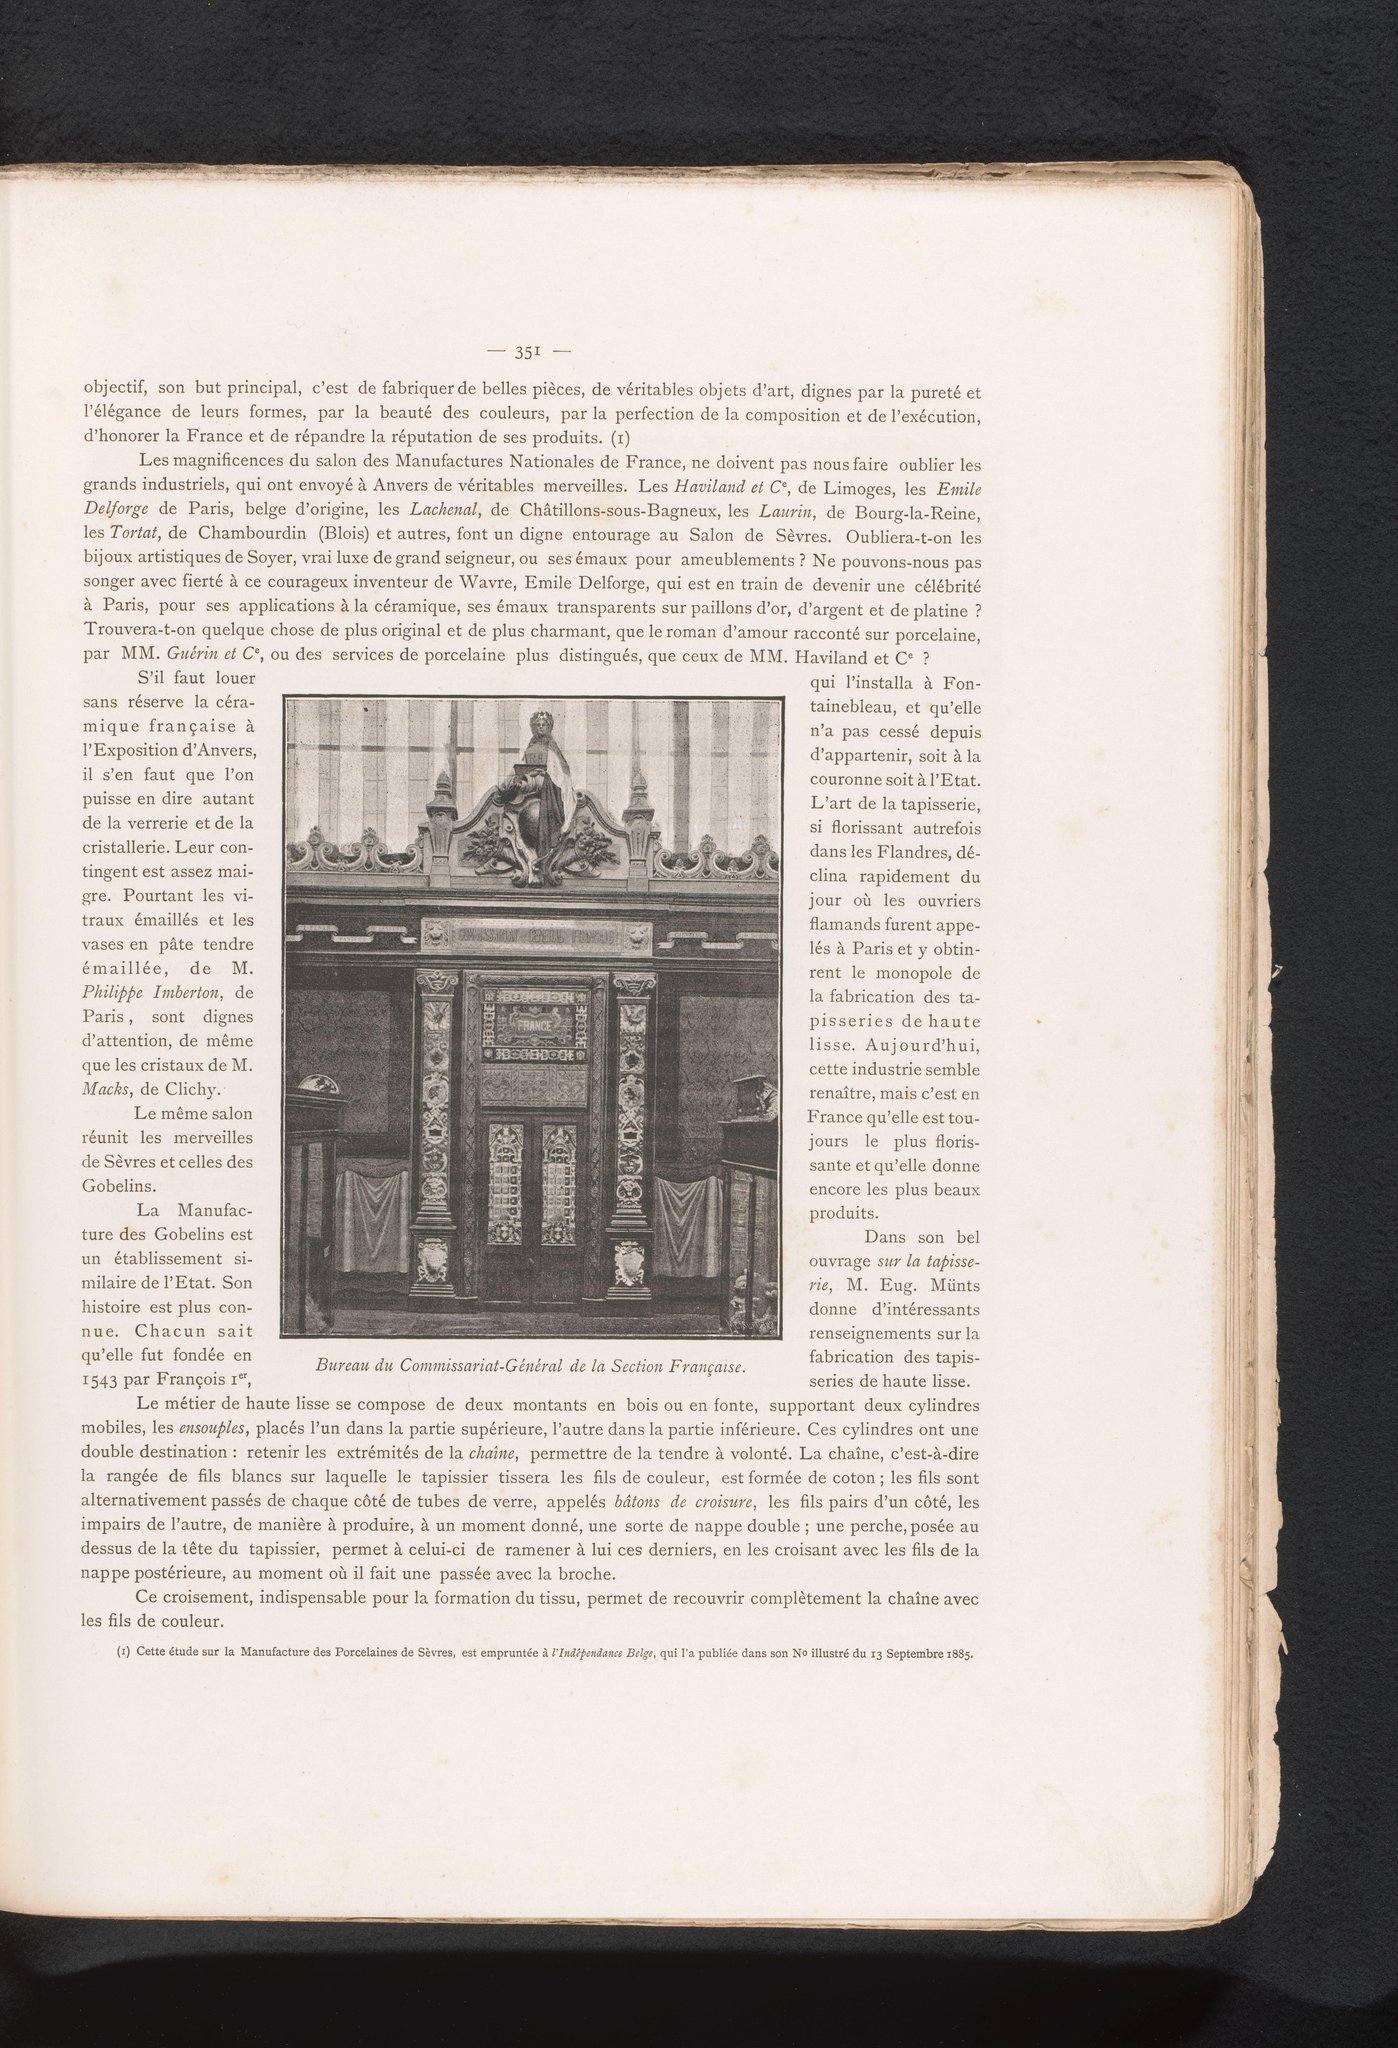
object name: page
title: Bureau du Commissariat-Général de la Section Française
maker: Anonymous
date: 1880-1885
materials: paper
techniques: autotype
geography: antwerp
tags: world fair, world exhibition, antwerp